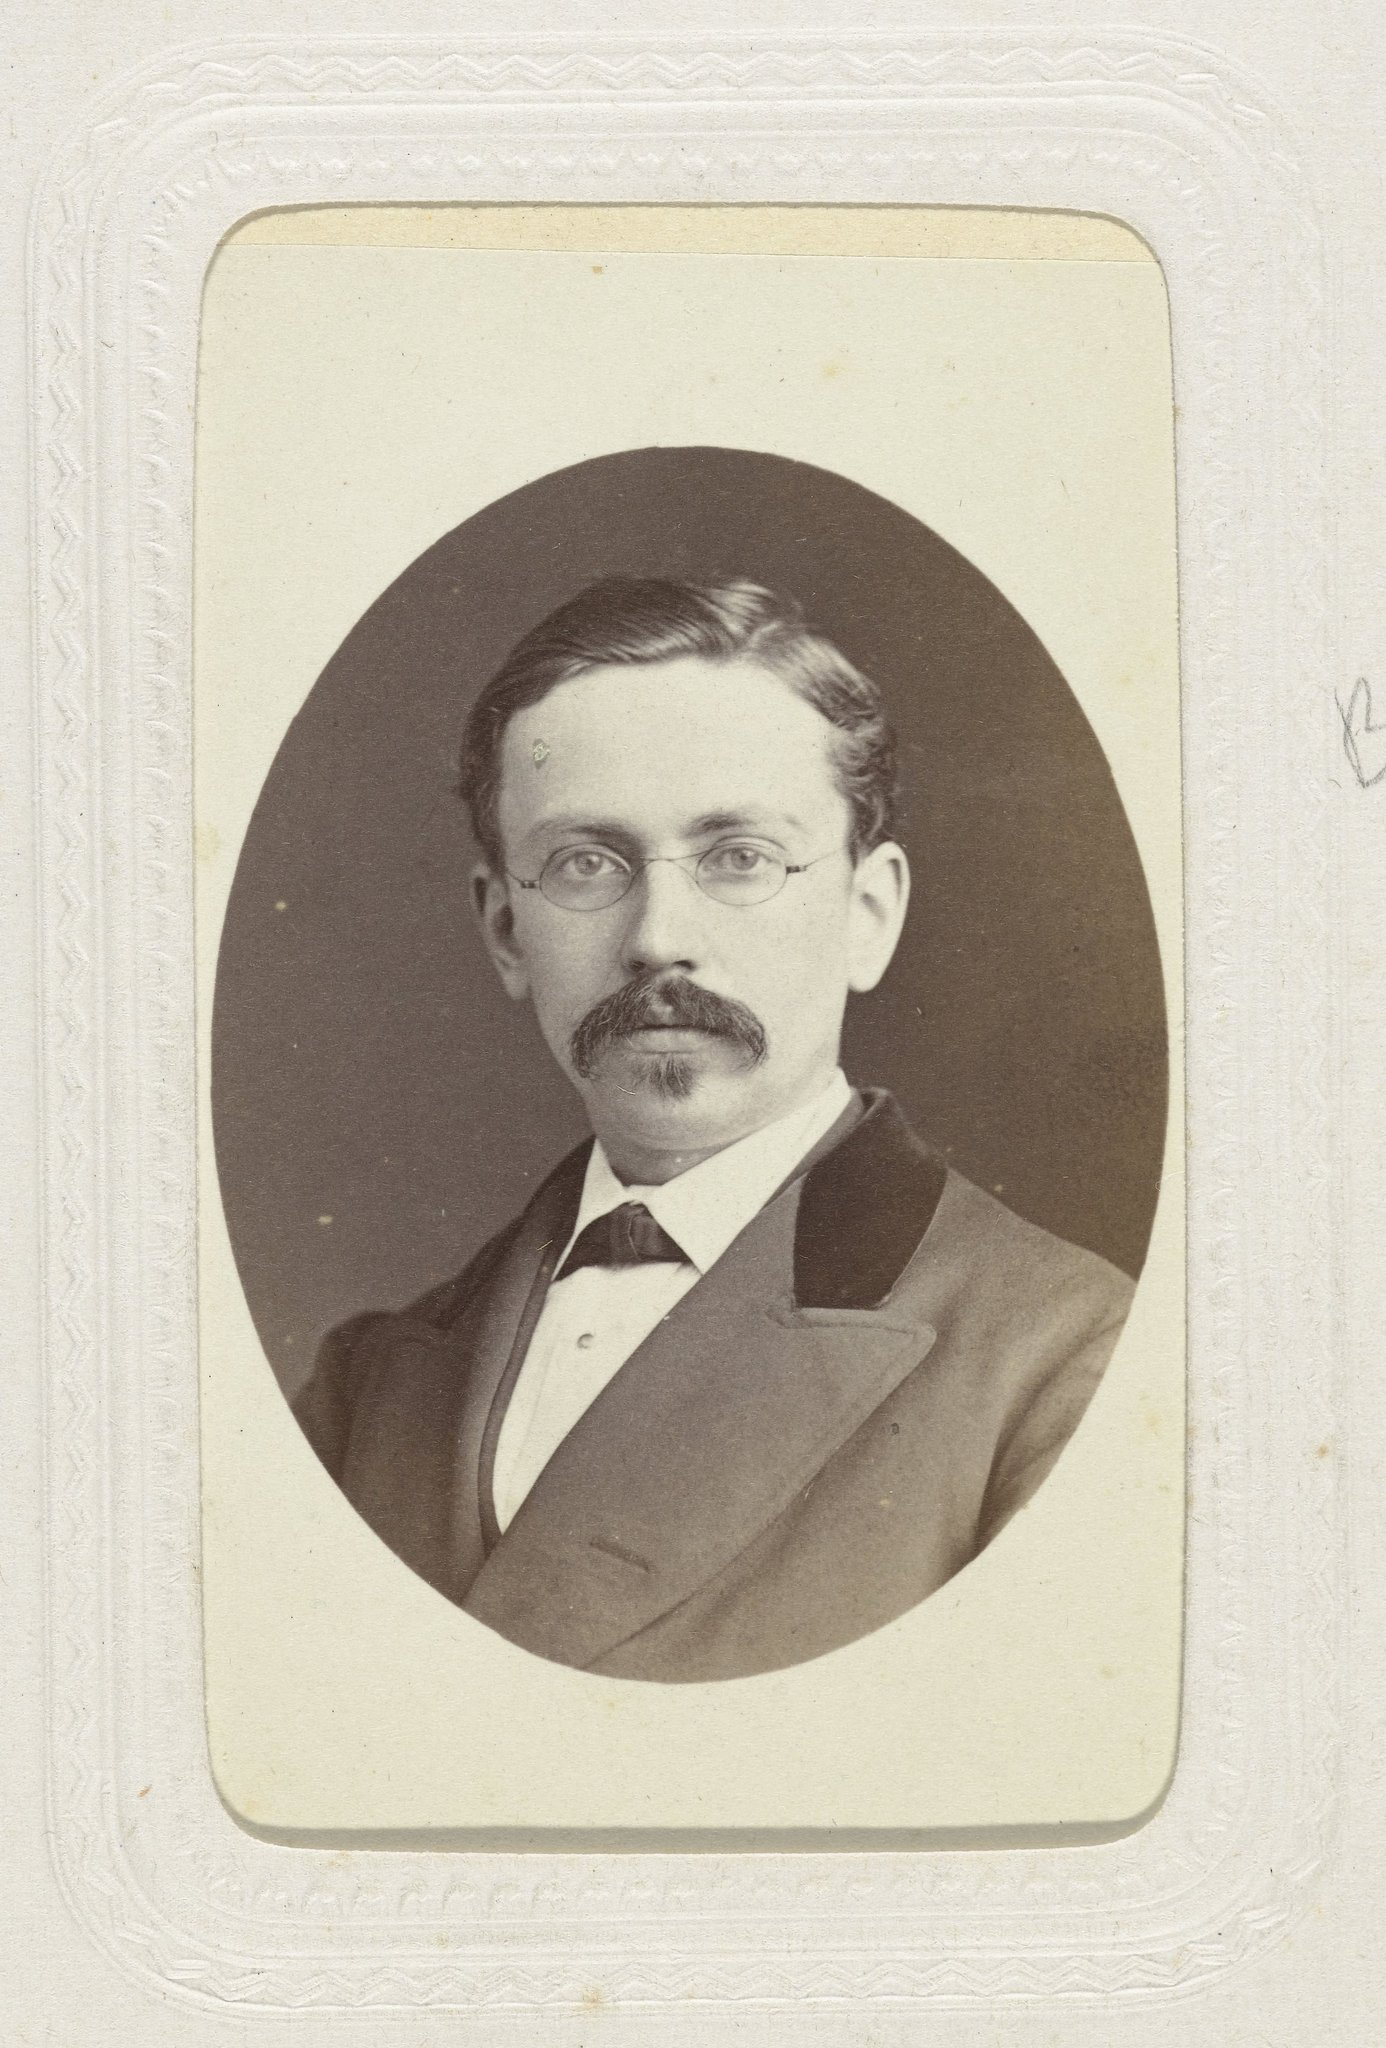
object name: carte de visite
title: Studioportret van een man met baard en bril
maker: bernardus bruining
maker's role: fotograaf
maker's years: 1834-1900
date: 1863-1870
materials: cardboard, paper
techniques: albumen print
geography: leiden